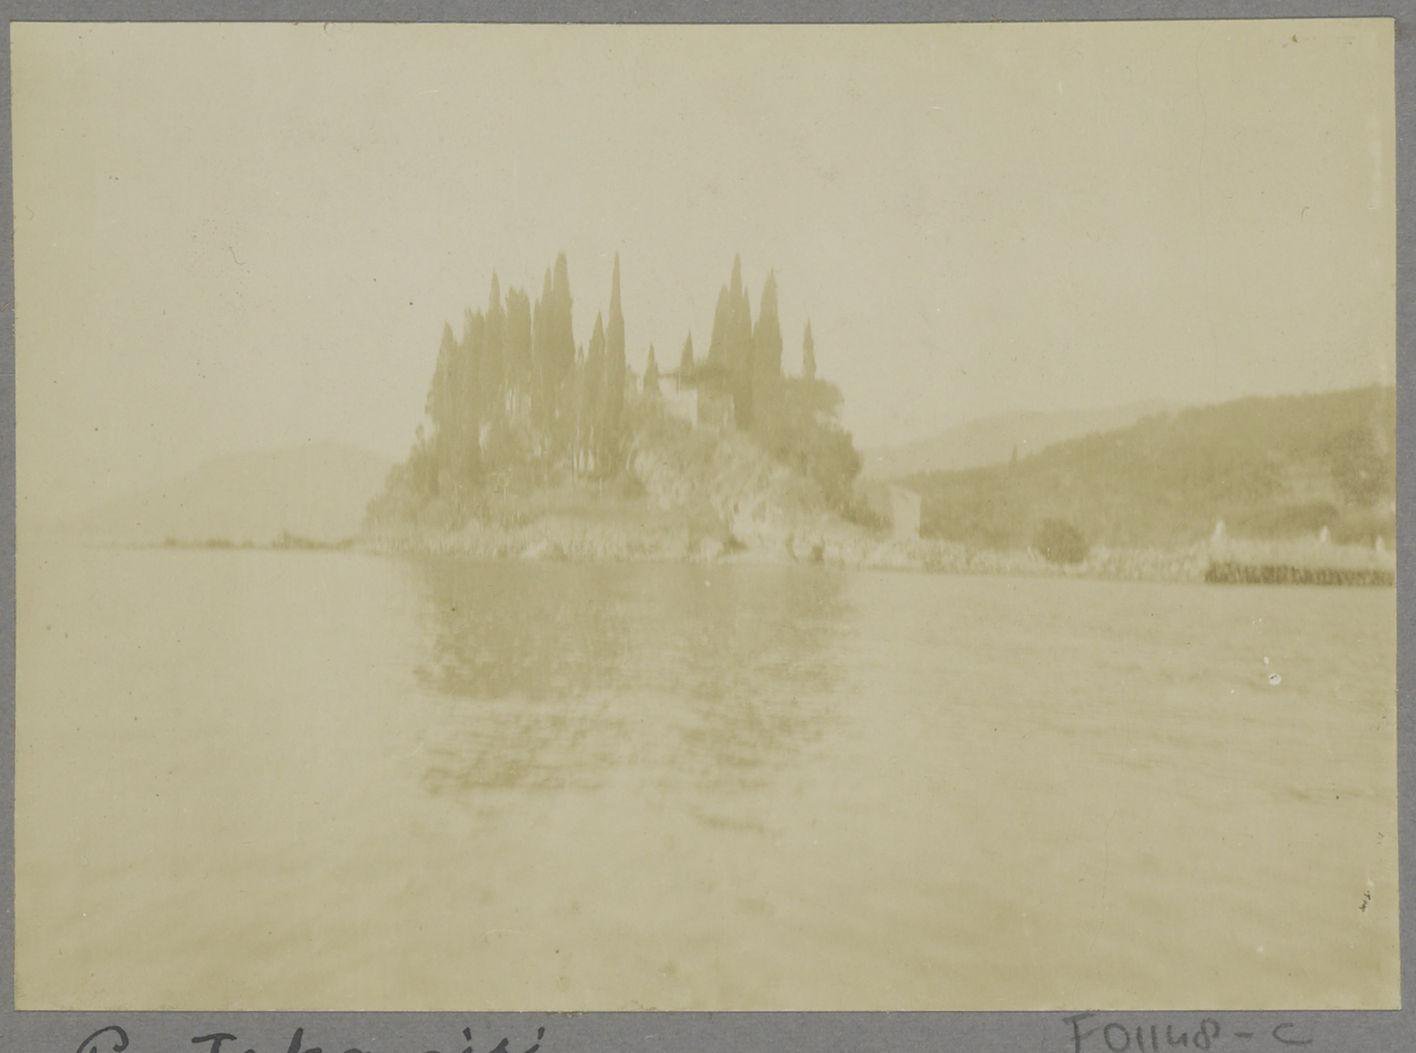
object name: album leaf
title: Gezicht op Pontikonisi bij Corfu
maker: Anonymous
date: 1905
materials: paper, photographic support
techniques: gelatin silver print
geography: corfu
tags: island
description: Onderdeel van Reisalbum met foto's van bezienswaardigheden in Griekenland en Egypte.